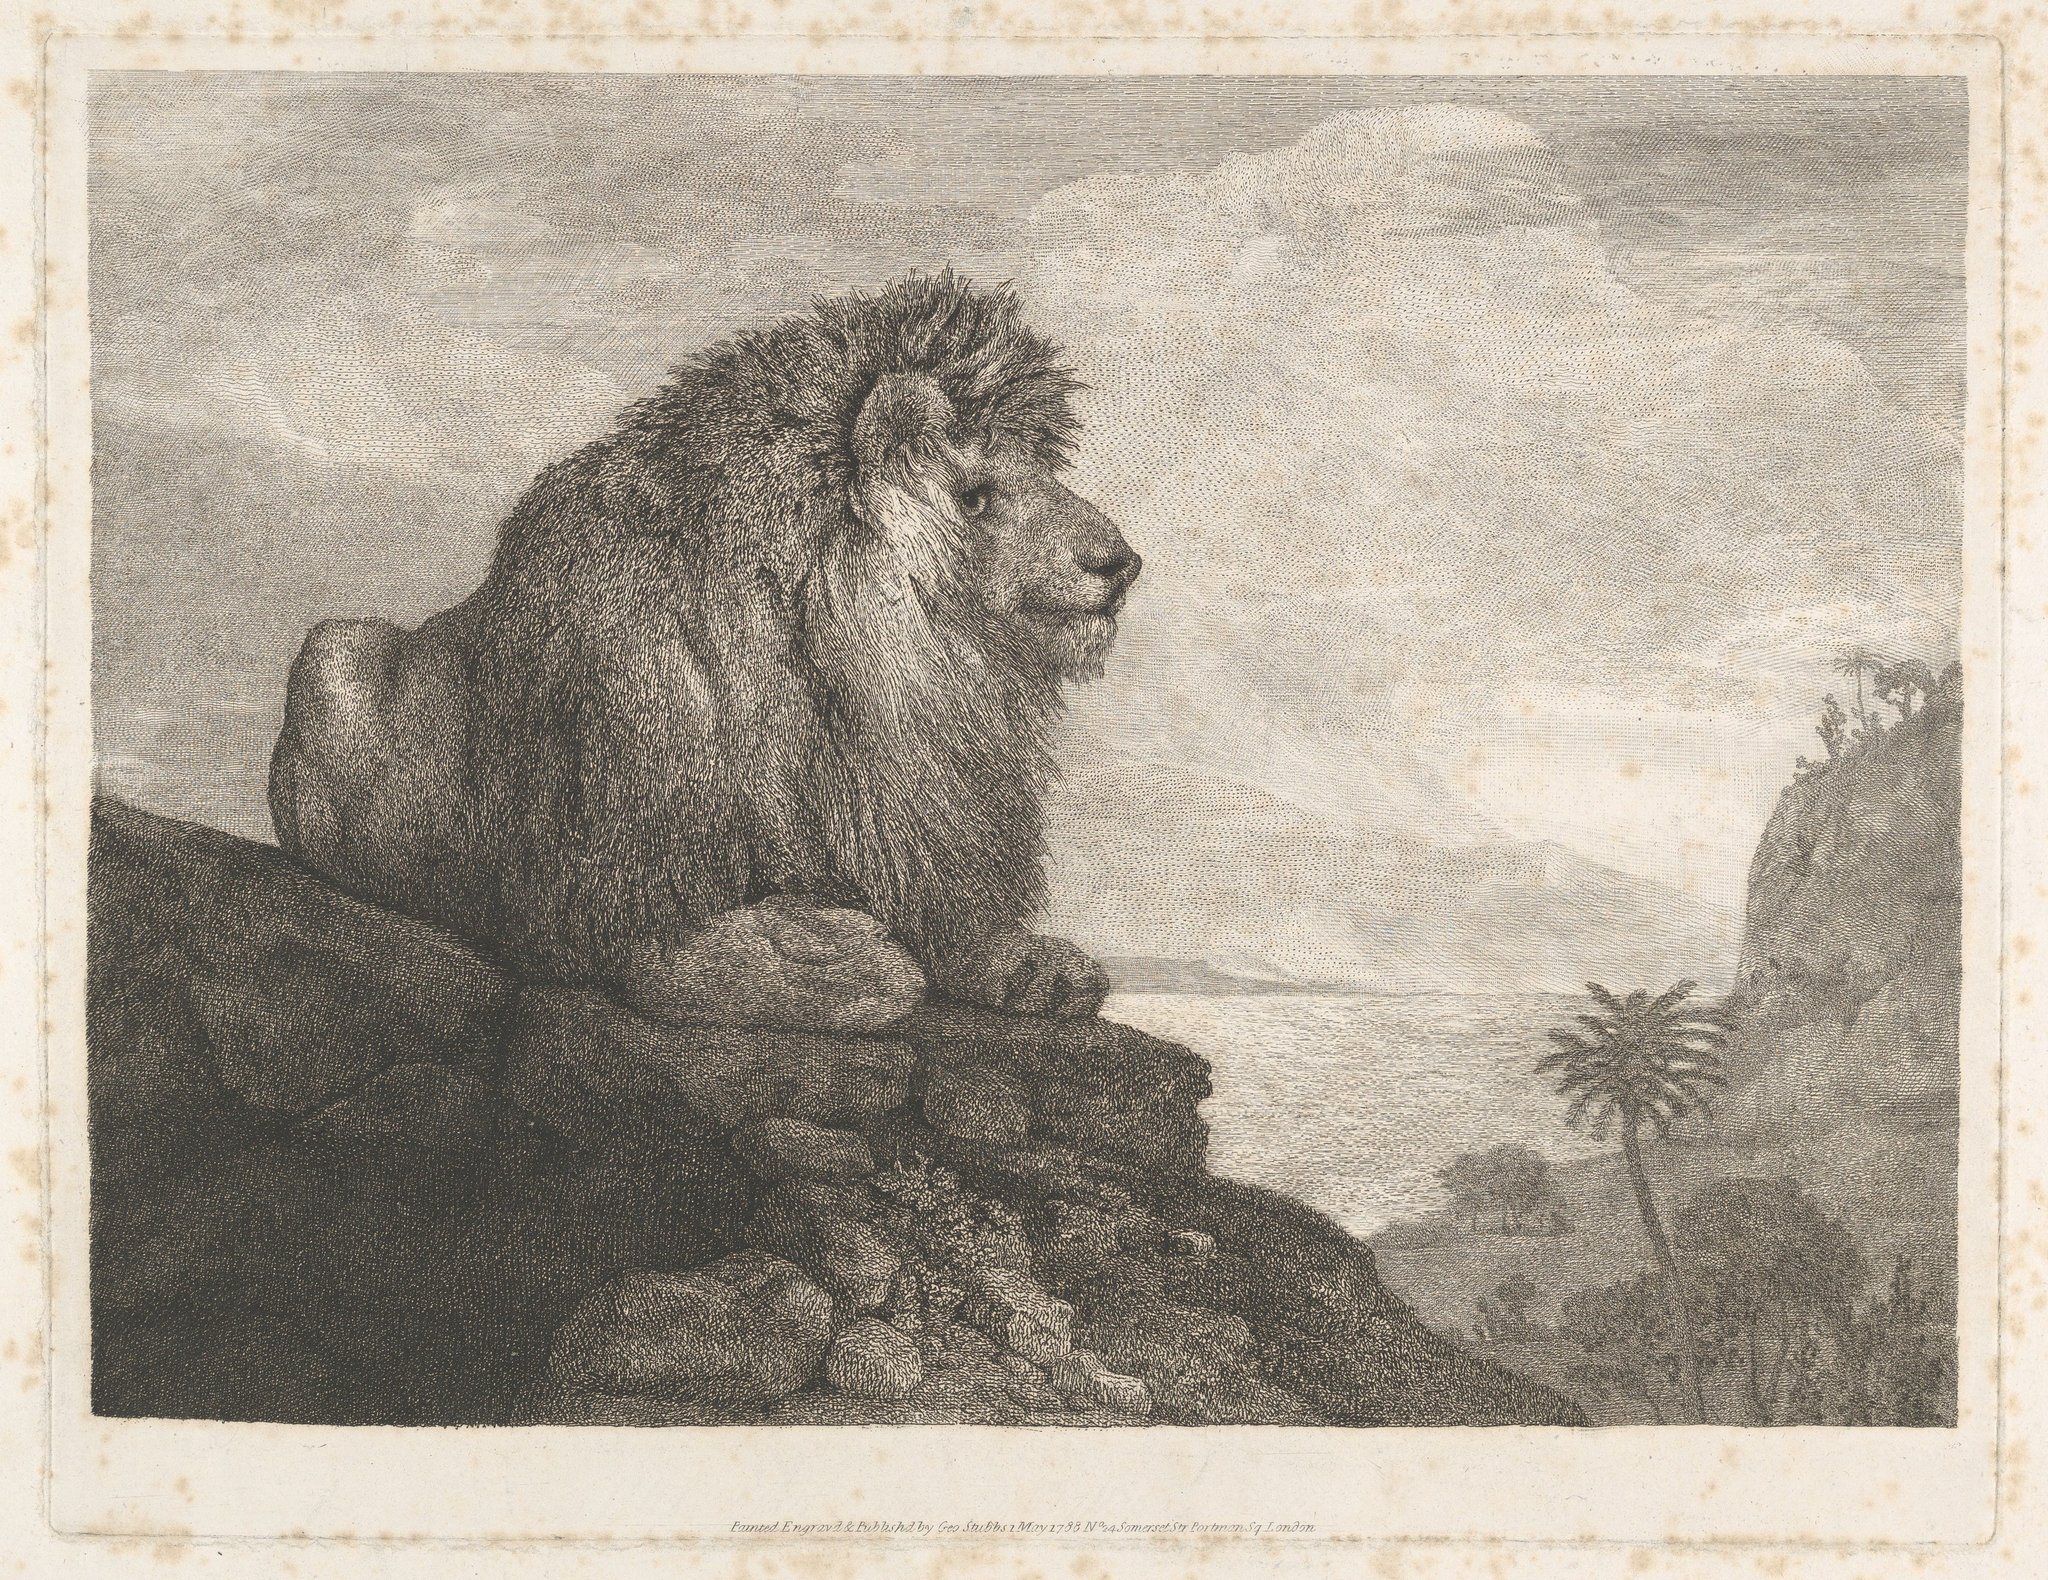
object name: print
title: A Lion (A Lion Resting on a Rock)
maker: george stubbs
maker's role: artist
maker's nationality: british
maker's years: 1724-1806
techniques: etching, roulette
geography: england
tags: lions